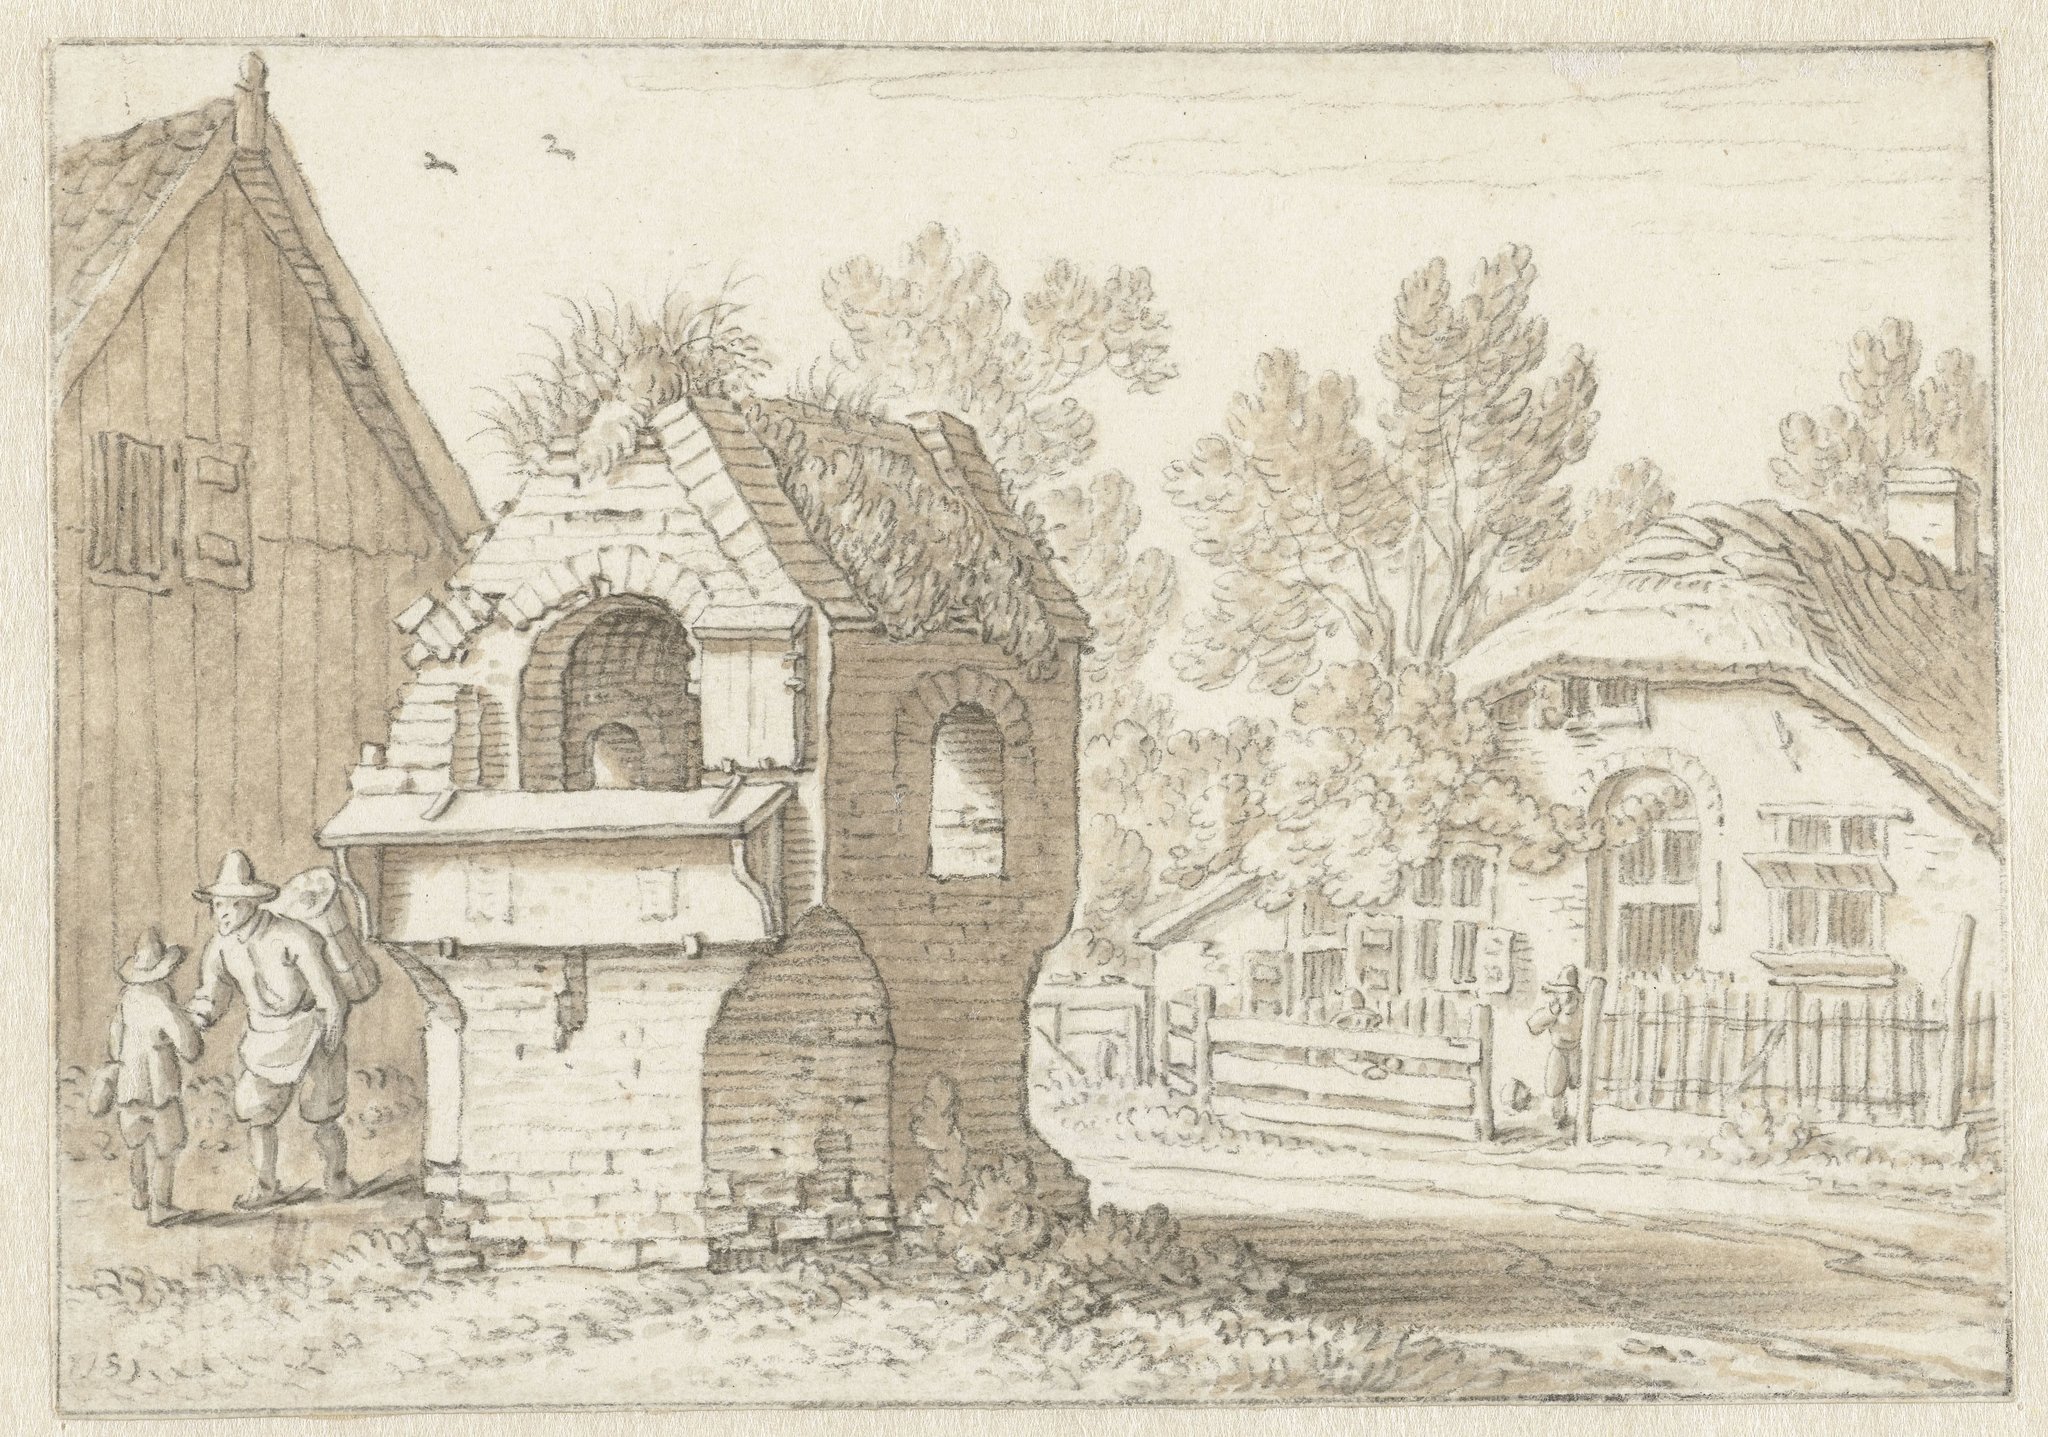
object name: drawing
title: St. Petronella's kapel in De Bilt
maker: herman saftleven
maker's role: draughtsman, painter, print maker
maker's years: 1609-1685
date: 1619-1685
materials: chalk, paper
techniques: brush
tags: church (exterior) - qq - small church, chapel